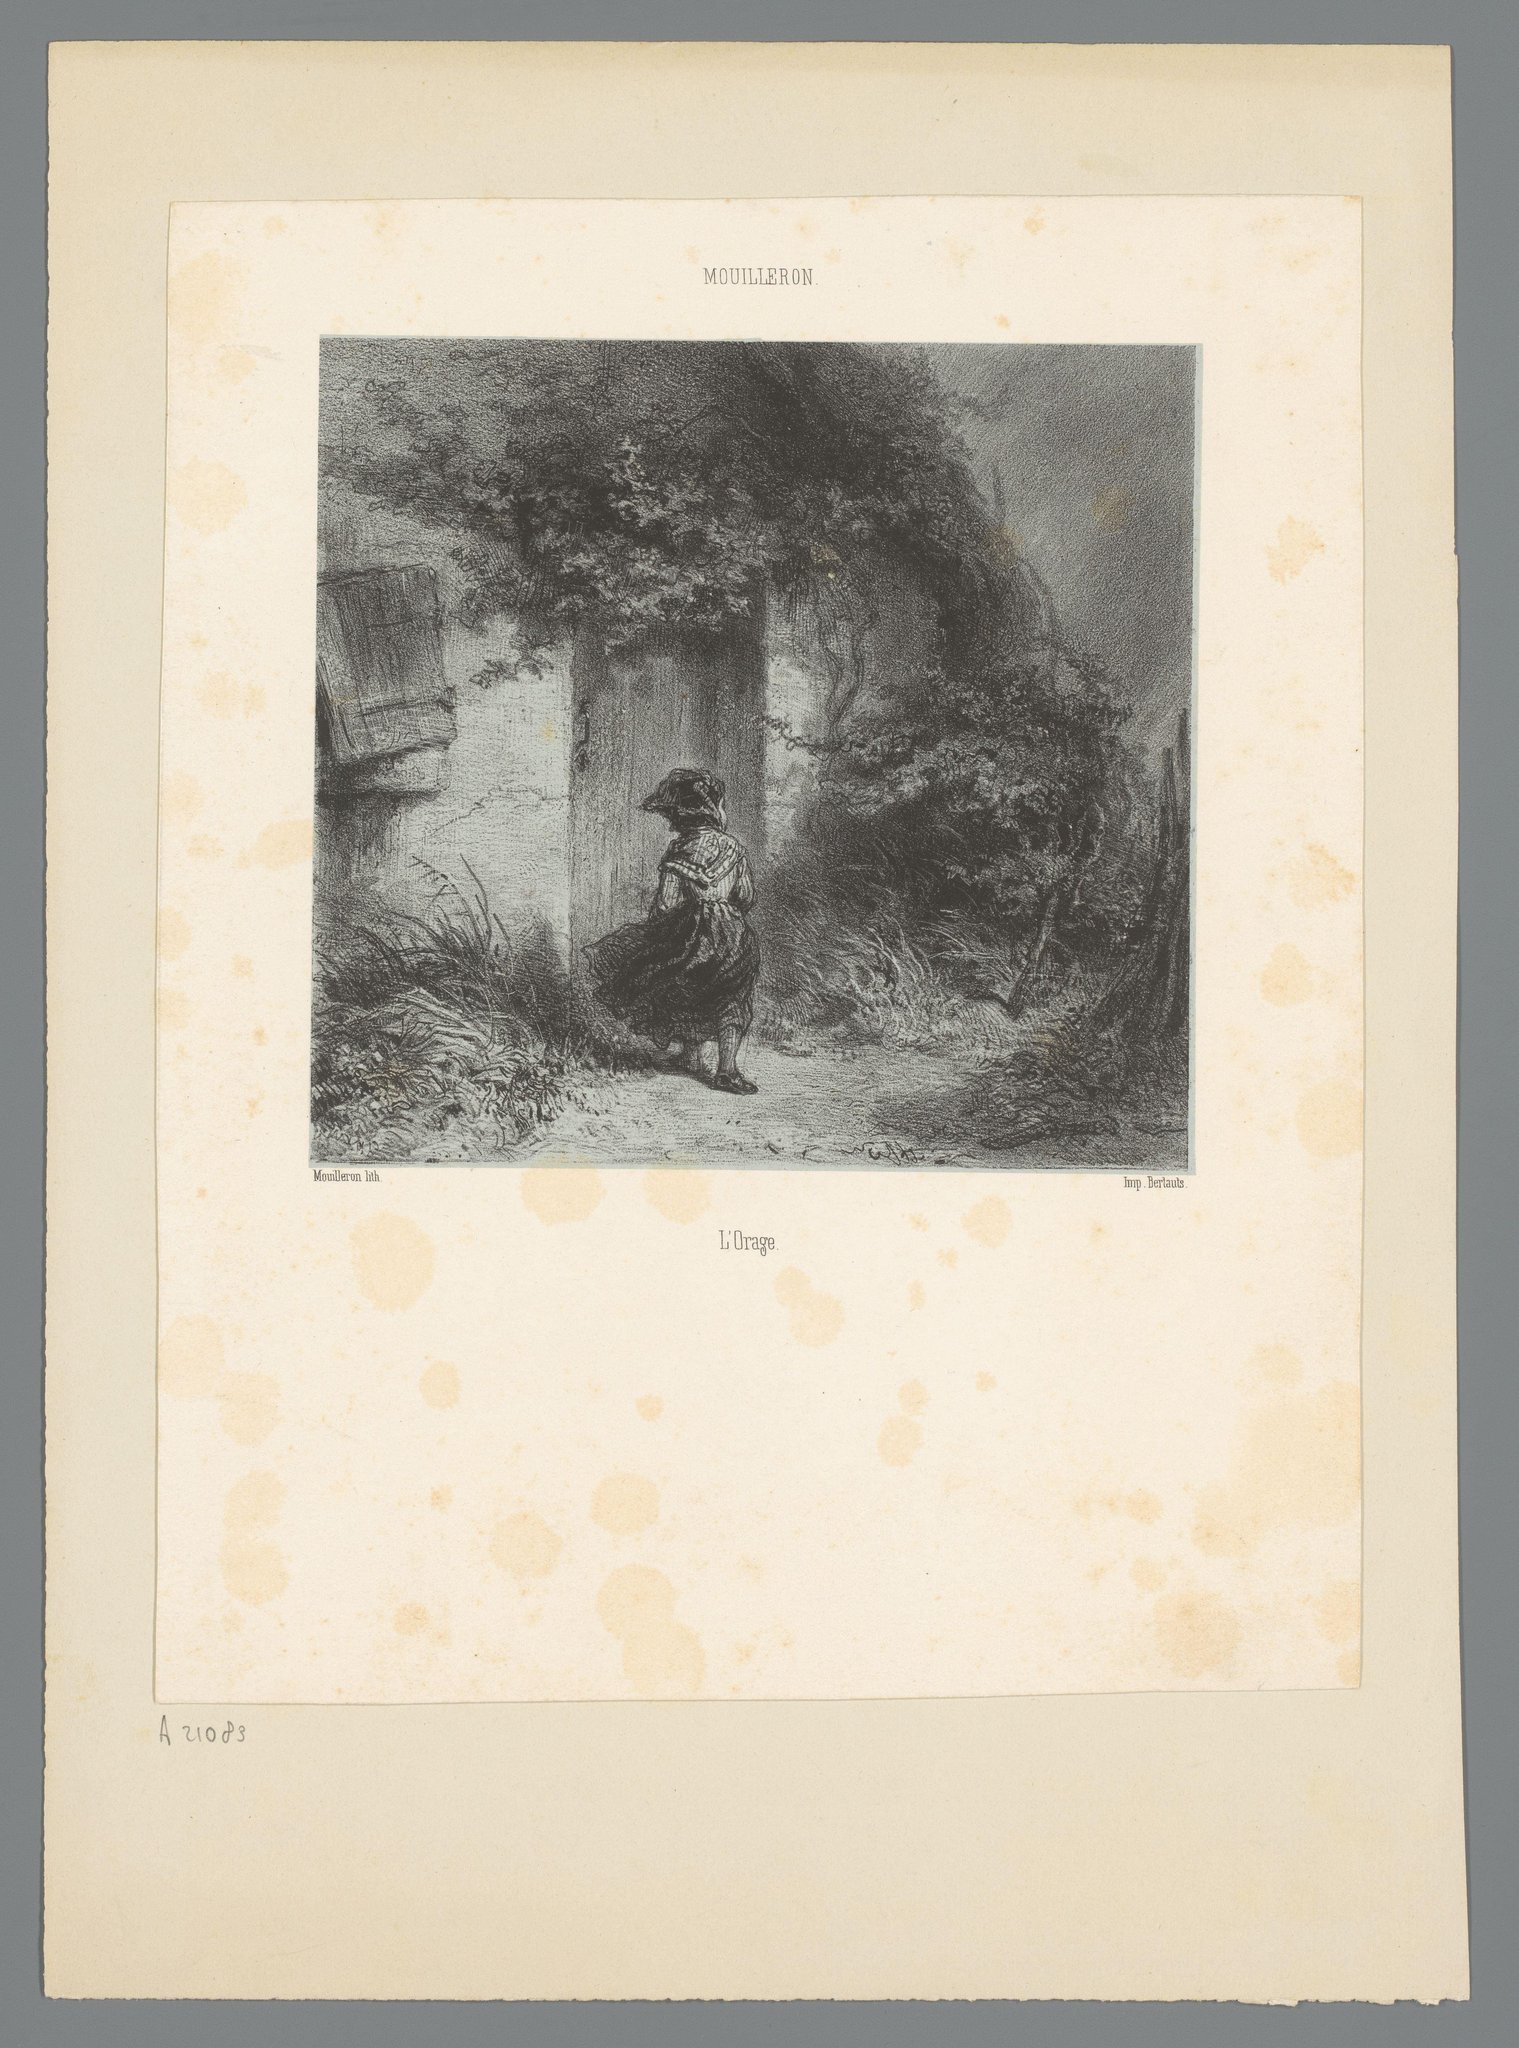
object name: print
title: L'orage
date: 1844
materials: paper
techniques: lithograph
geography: paris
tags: childhood sorrows, thunderstorm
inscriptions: collector's mark: Lugt 964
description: Prent verschenen in: Les Beaux-Arts. Illustration des arts et de la littérature. Deel 3. Parijs: Léon Curmer, 1844.